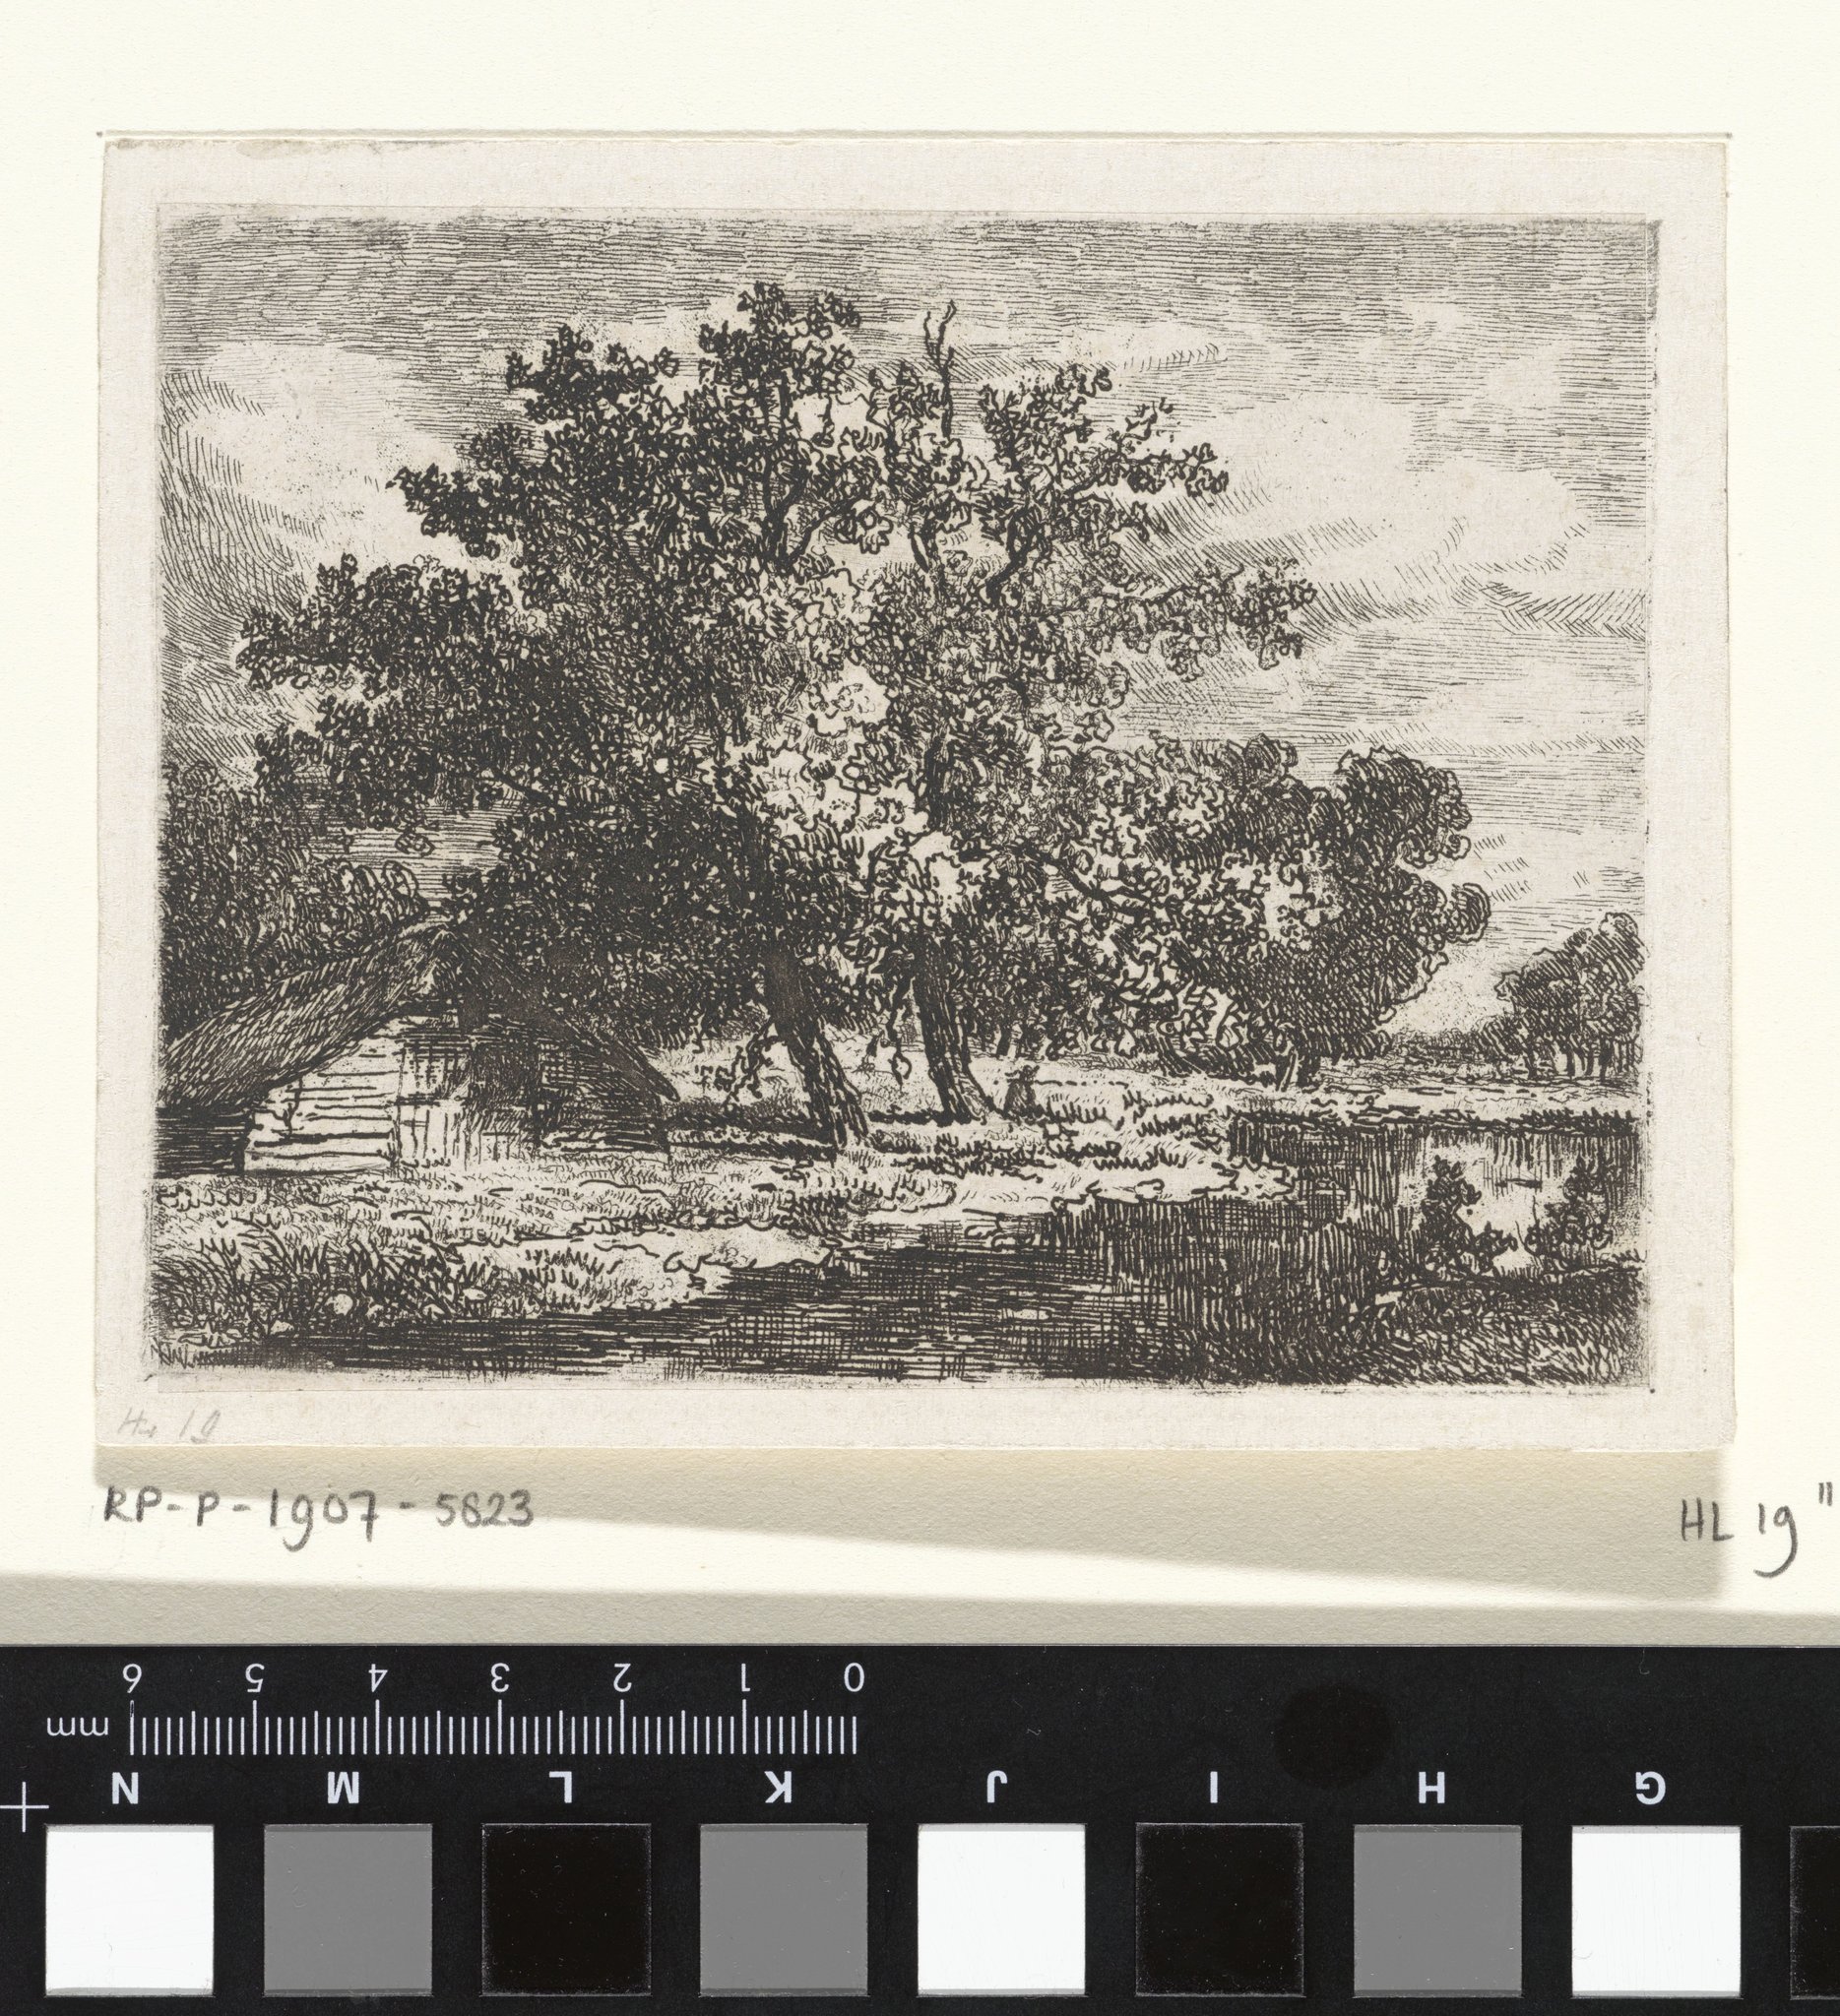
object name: print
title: Houten hut onder twee bomen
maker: johannes pieter van wisselingh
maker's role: draughtsman, painter, print maker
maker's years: 1812-1899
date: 1830-1878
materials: paper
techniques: etching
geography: netherlands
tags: trees, brook, hut, cabin, lodge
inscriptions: collector's mark: Lugt 2228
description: Links staat een houten hut onder twee bomen. Rechts stroomt een beek.